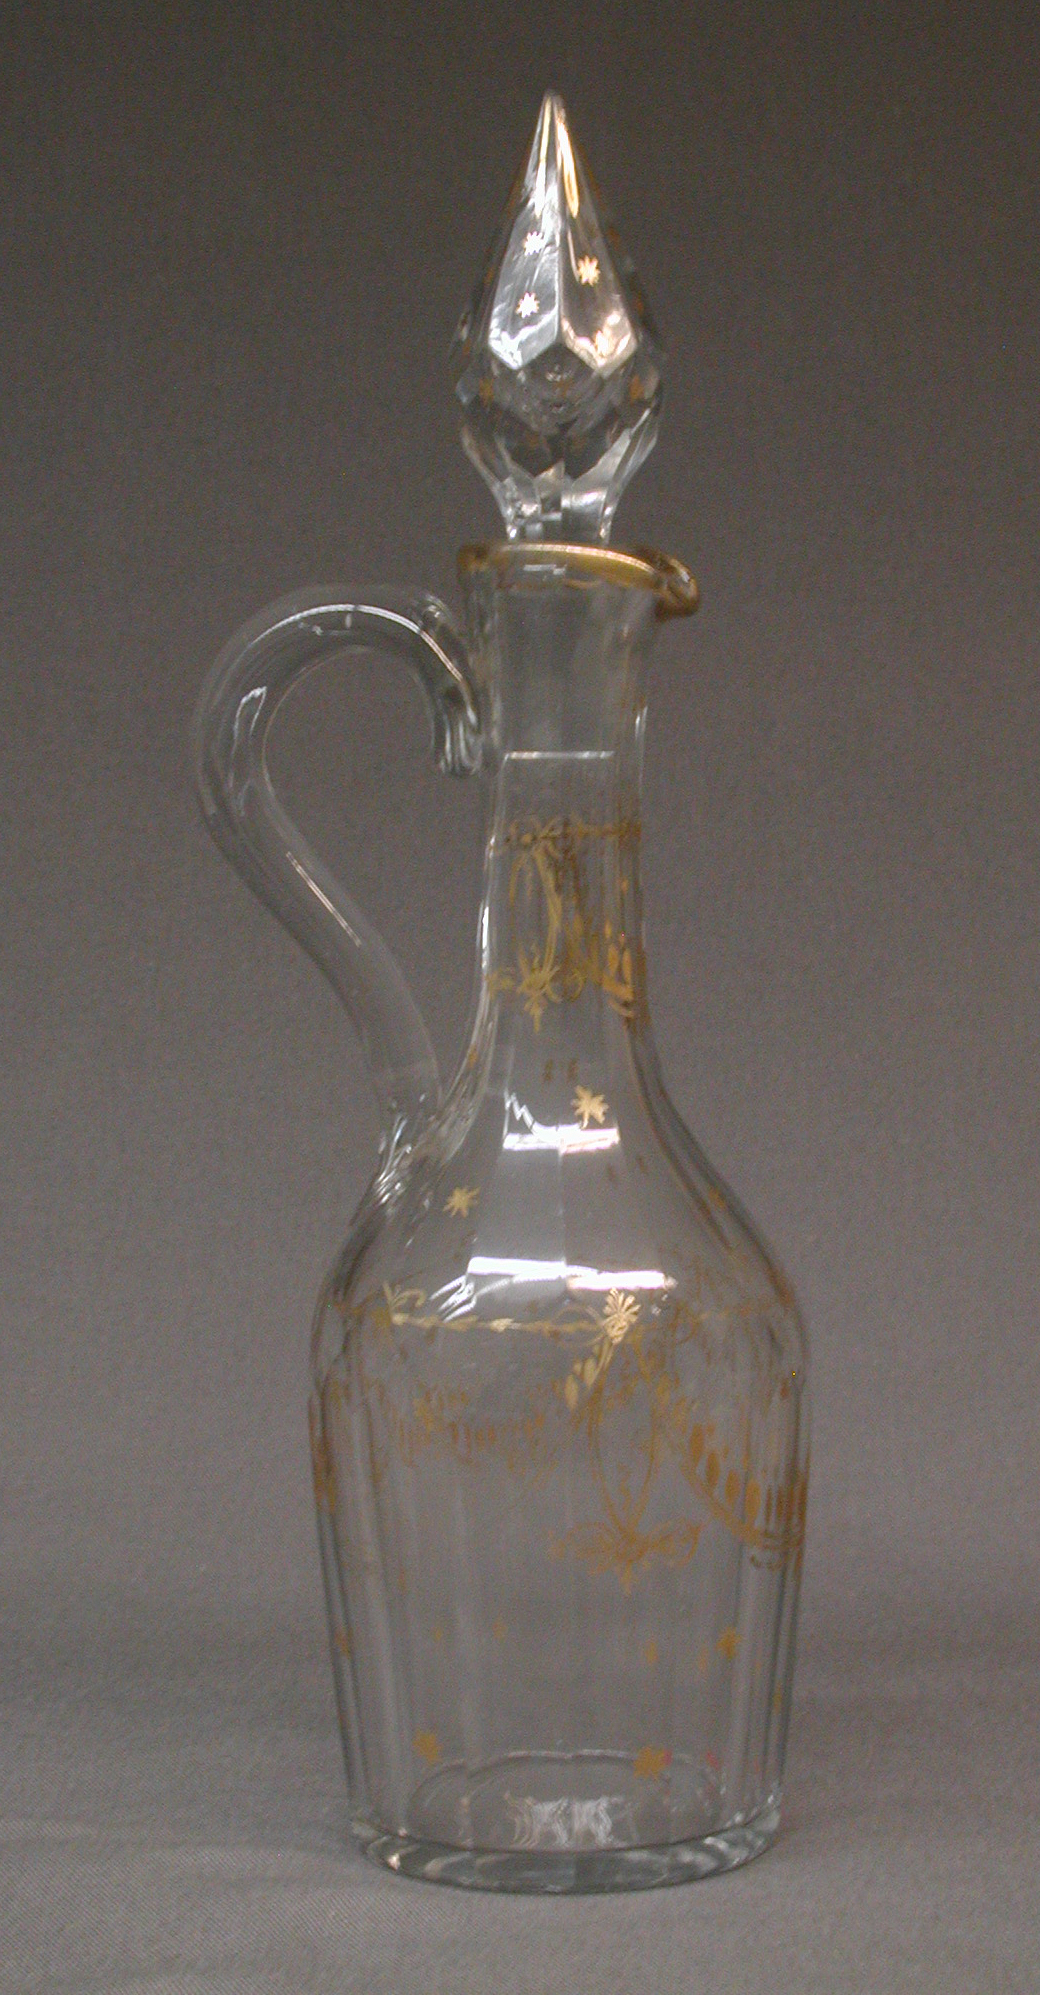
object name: cruet and stopper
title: Cruet with stopper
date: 1801-1900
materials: glass